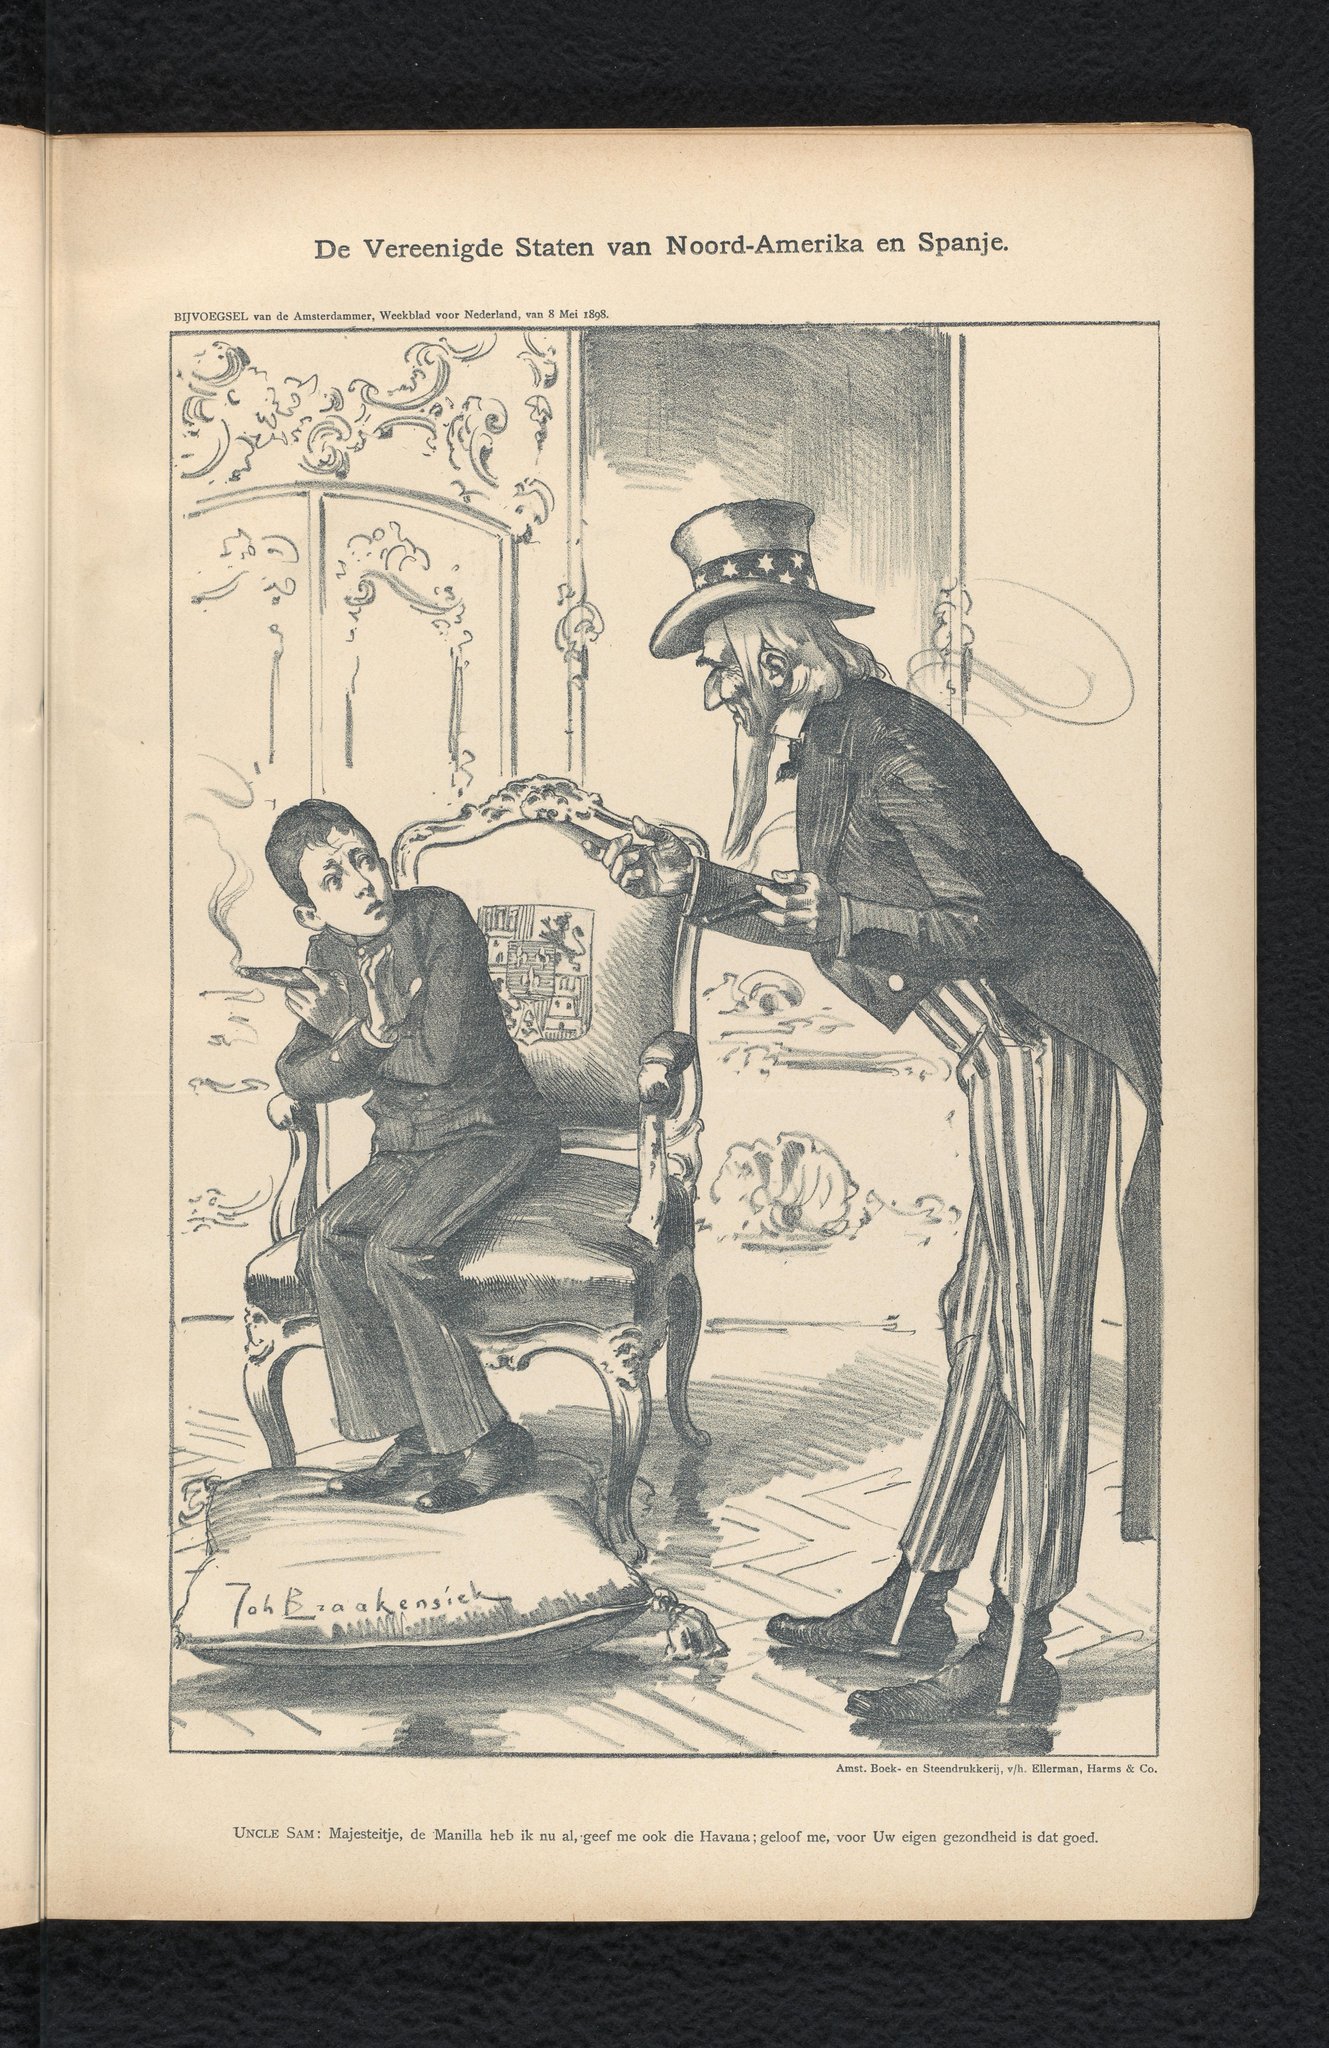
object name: cartoon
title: De Vereenigde Staten van Noord-Amerika en Spanje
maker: johan braakensiek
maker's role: draughtsman, print maker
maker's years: 1858-1940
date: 1898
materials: paper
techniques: lithograph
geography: netherlands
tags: cigar, personifications of countries, nations, states, districts, etc., political caricatures and satires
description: Uncle Sam vraagt de jonge Spaanse koning Alfons XIII, omwille van zijn eigen gezondheid, hem zijn Havana sigaar te geven. Naar aanleiding van de Spaans-Amerikaanse oorlog.